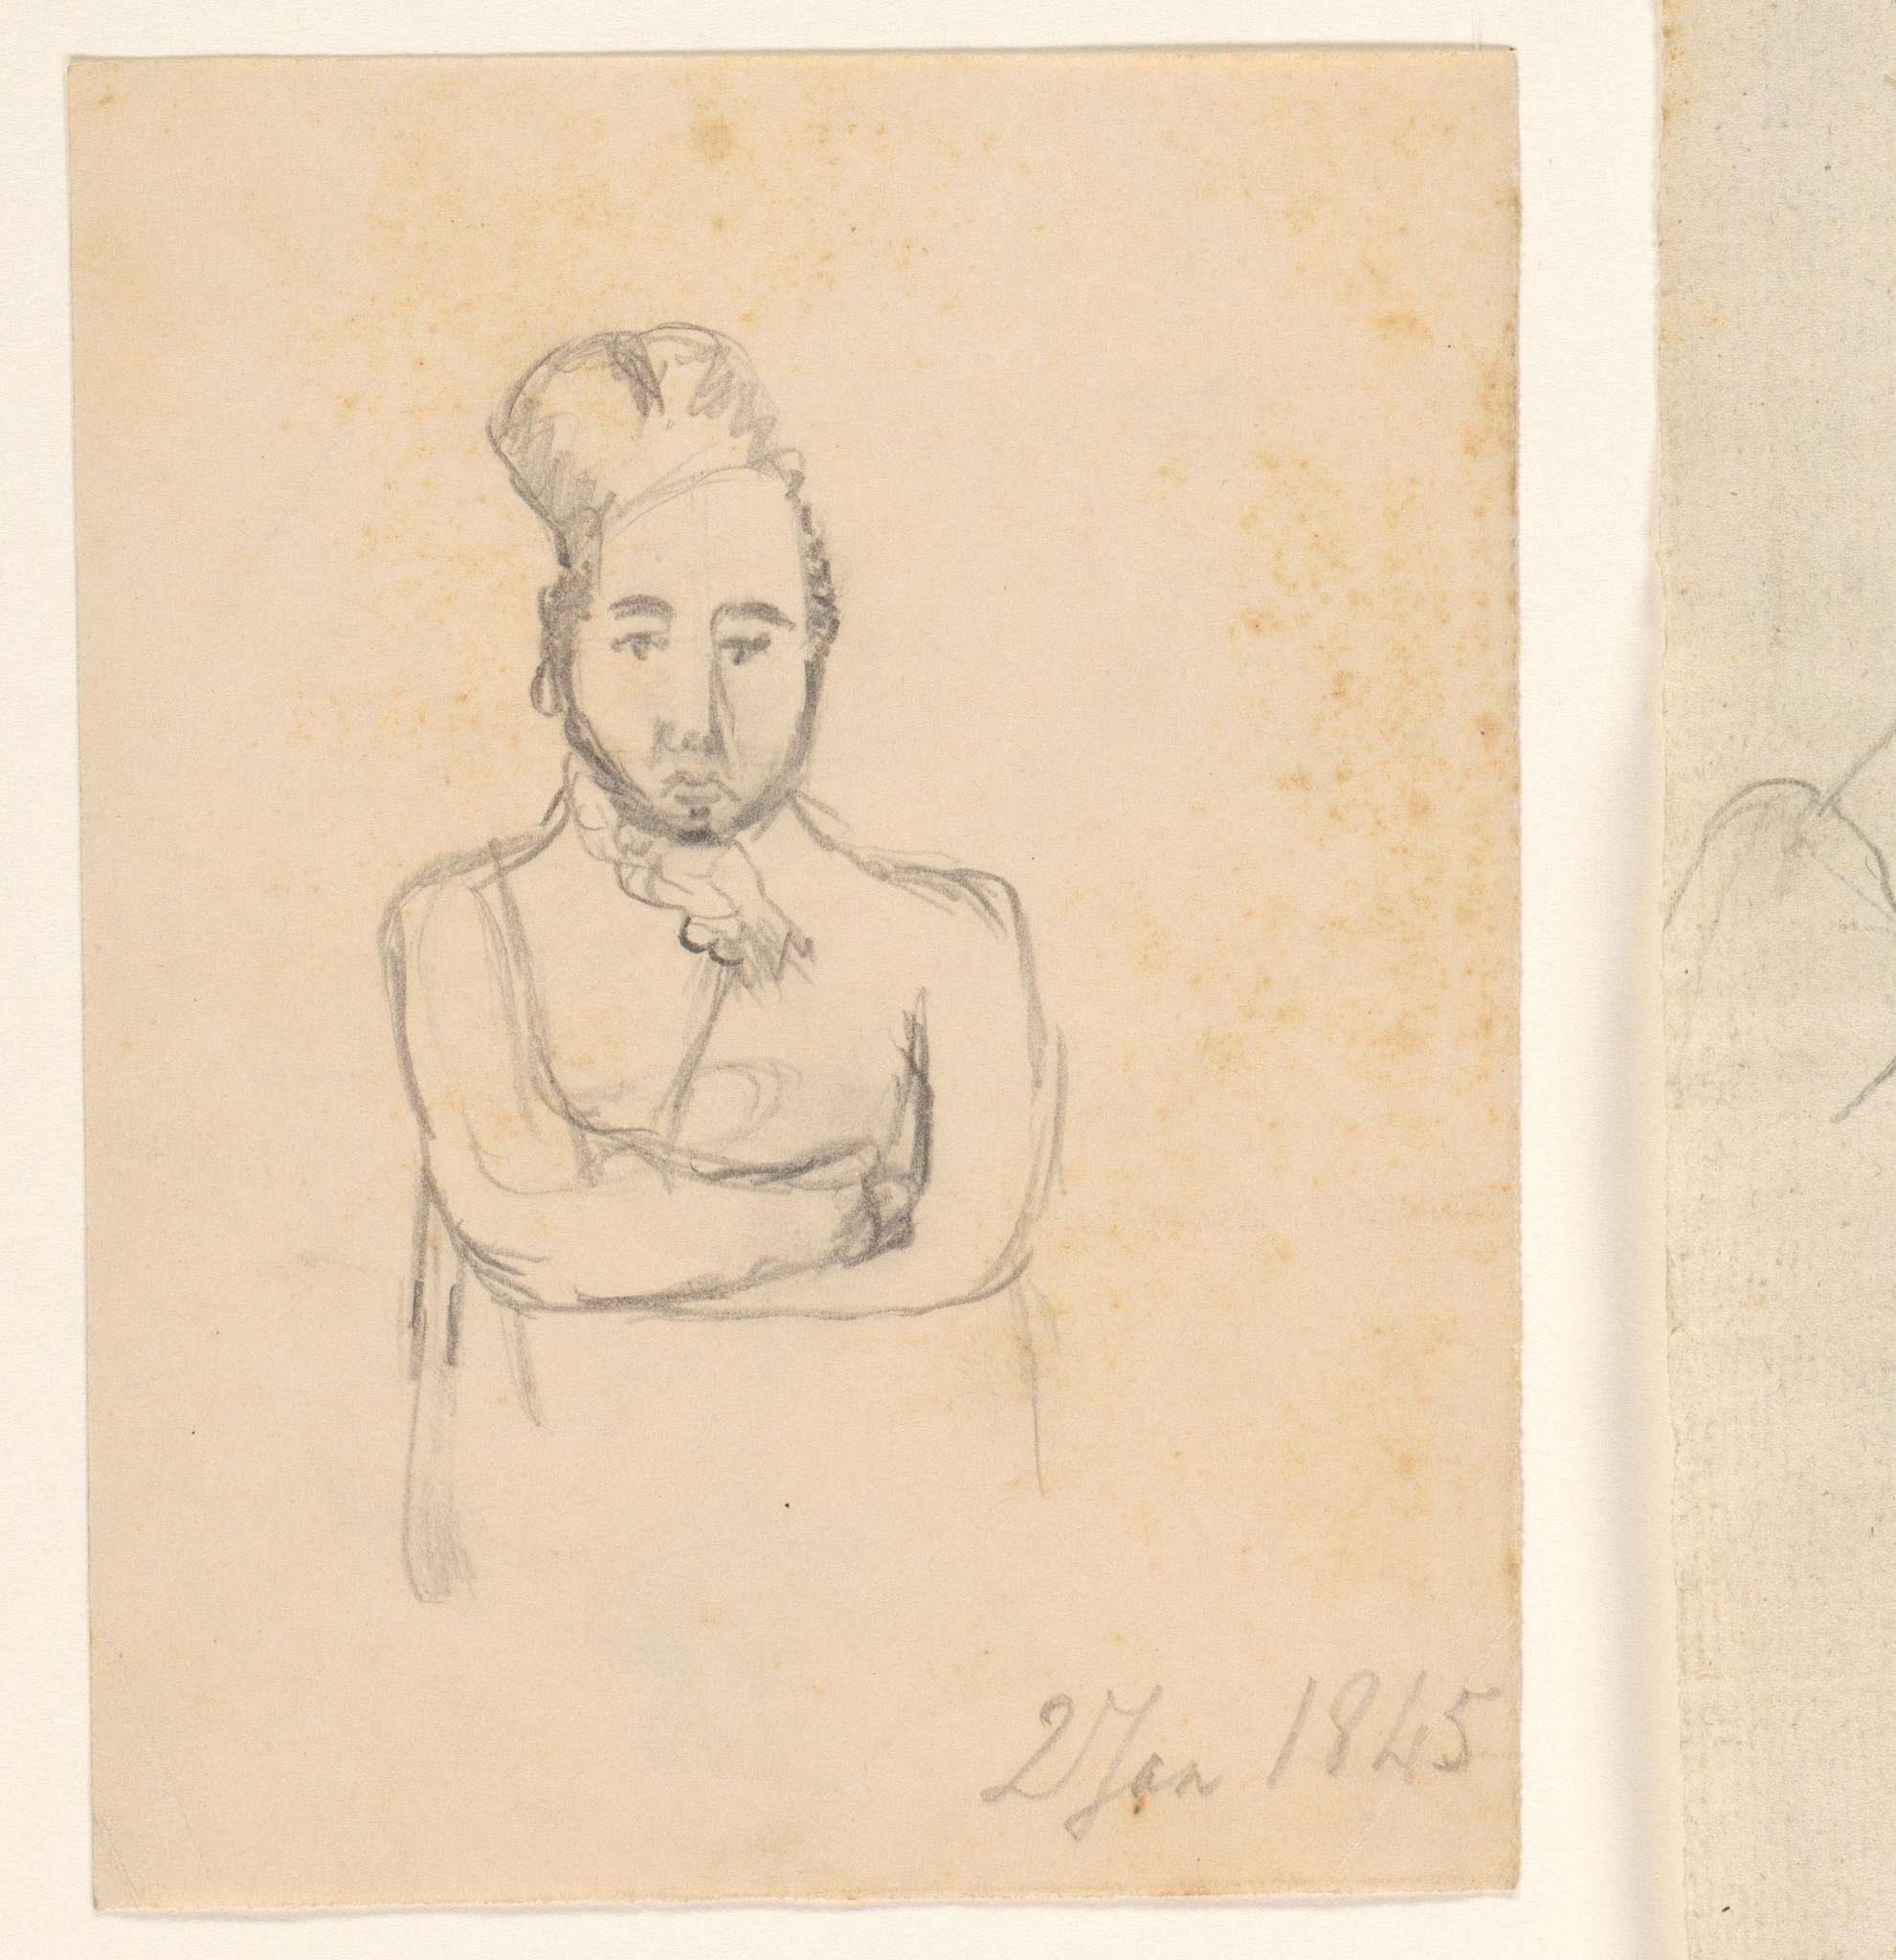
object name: drawing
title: Kok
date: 1845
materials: paper, pencil